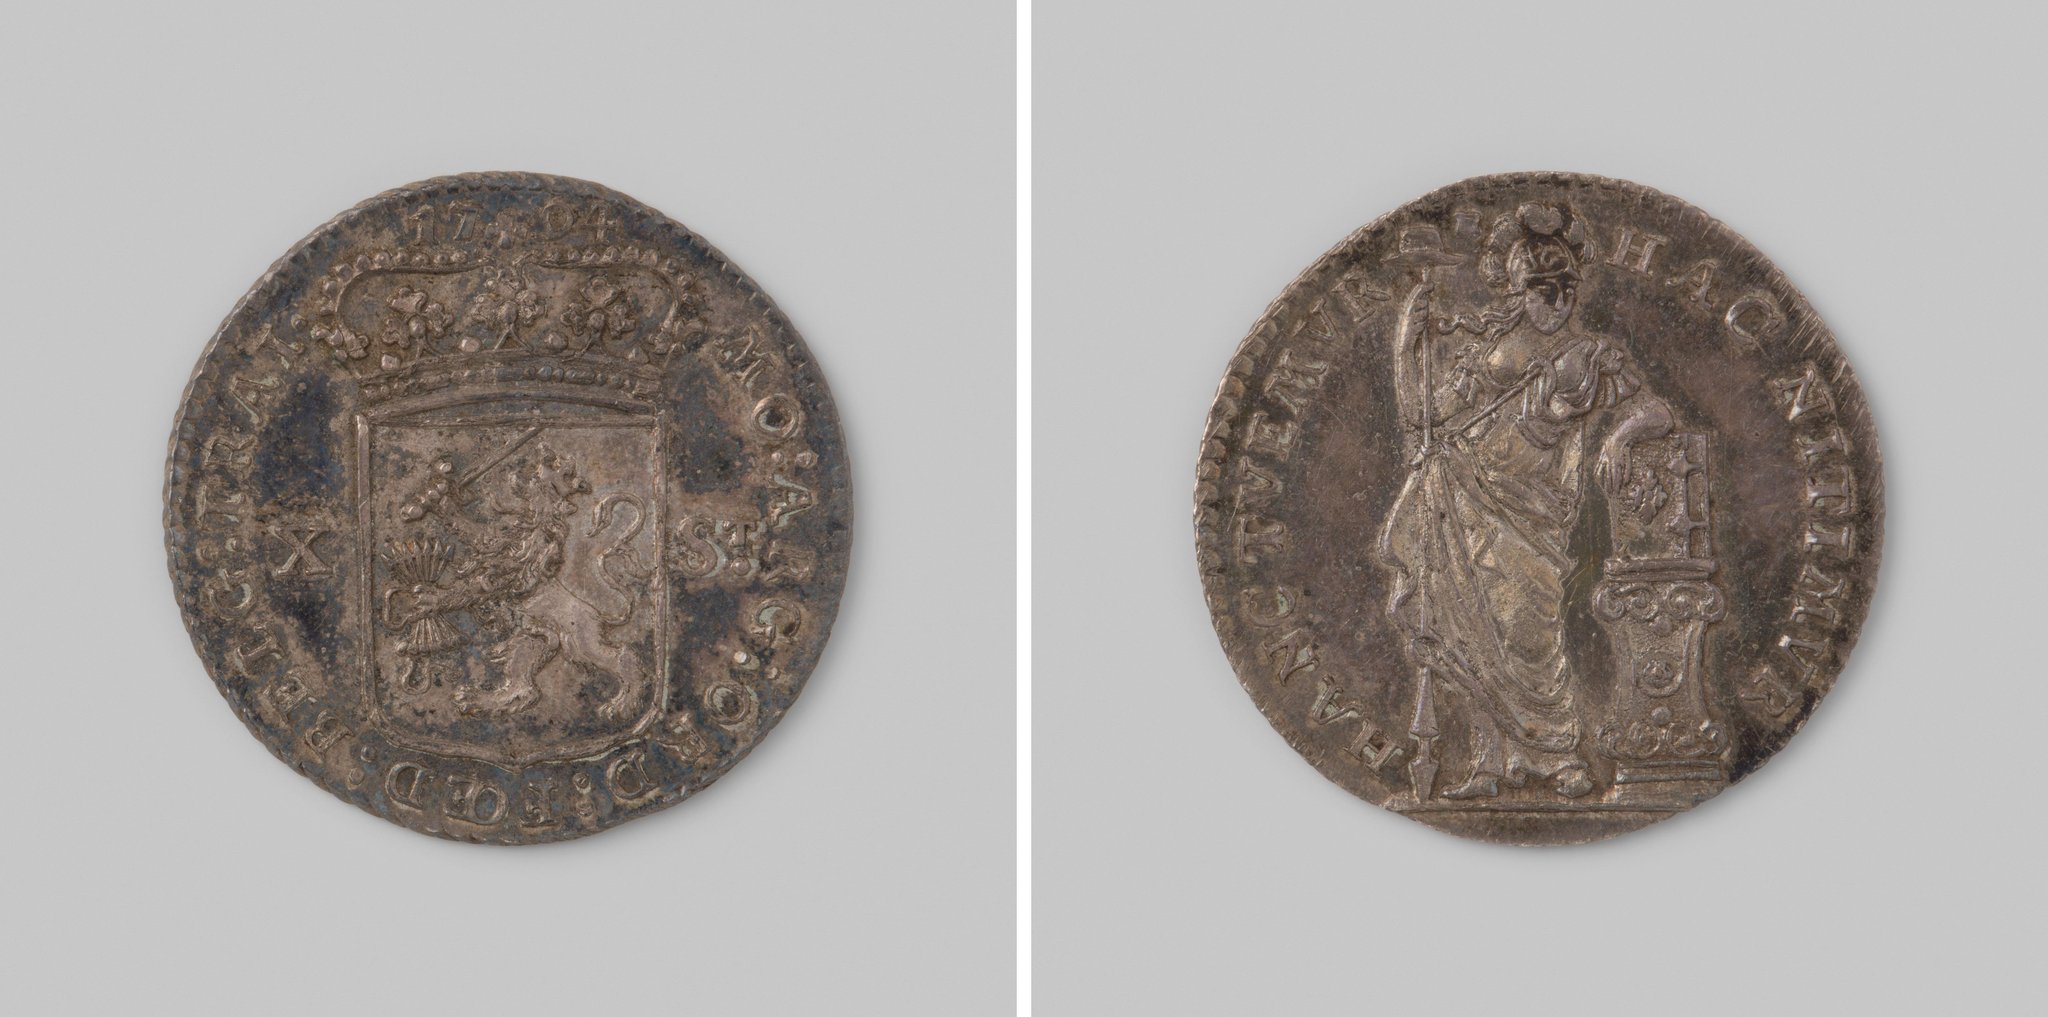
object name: coin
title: Utrecht, halve gulden, 1794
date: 1794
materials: silver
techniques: striking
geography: utrecht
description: Voorzijde: tussen waarde-aanduiding X St gekroond generaliteitswapenschild. Jaartal boven kroon. Keerzijde: Nederlandse maagd met vrijheidshoed en speer, leunend op een bijbel op een altaar. Kabelrand.